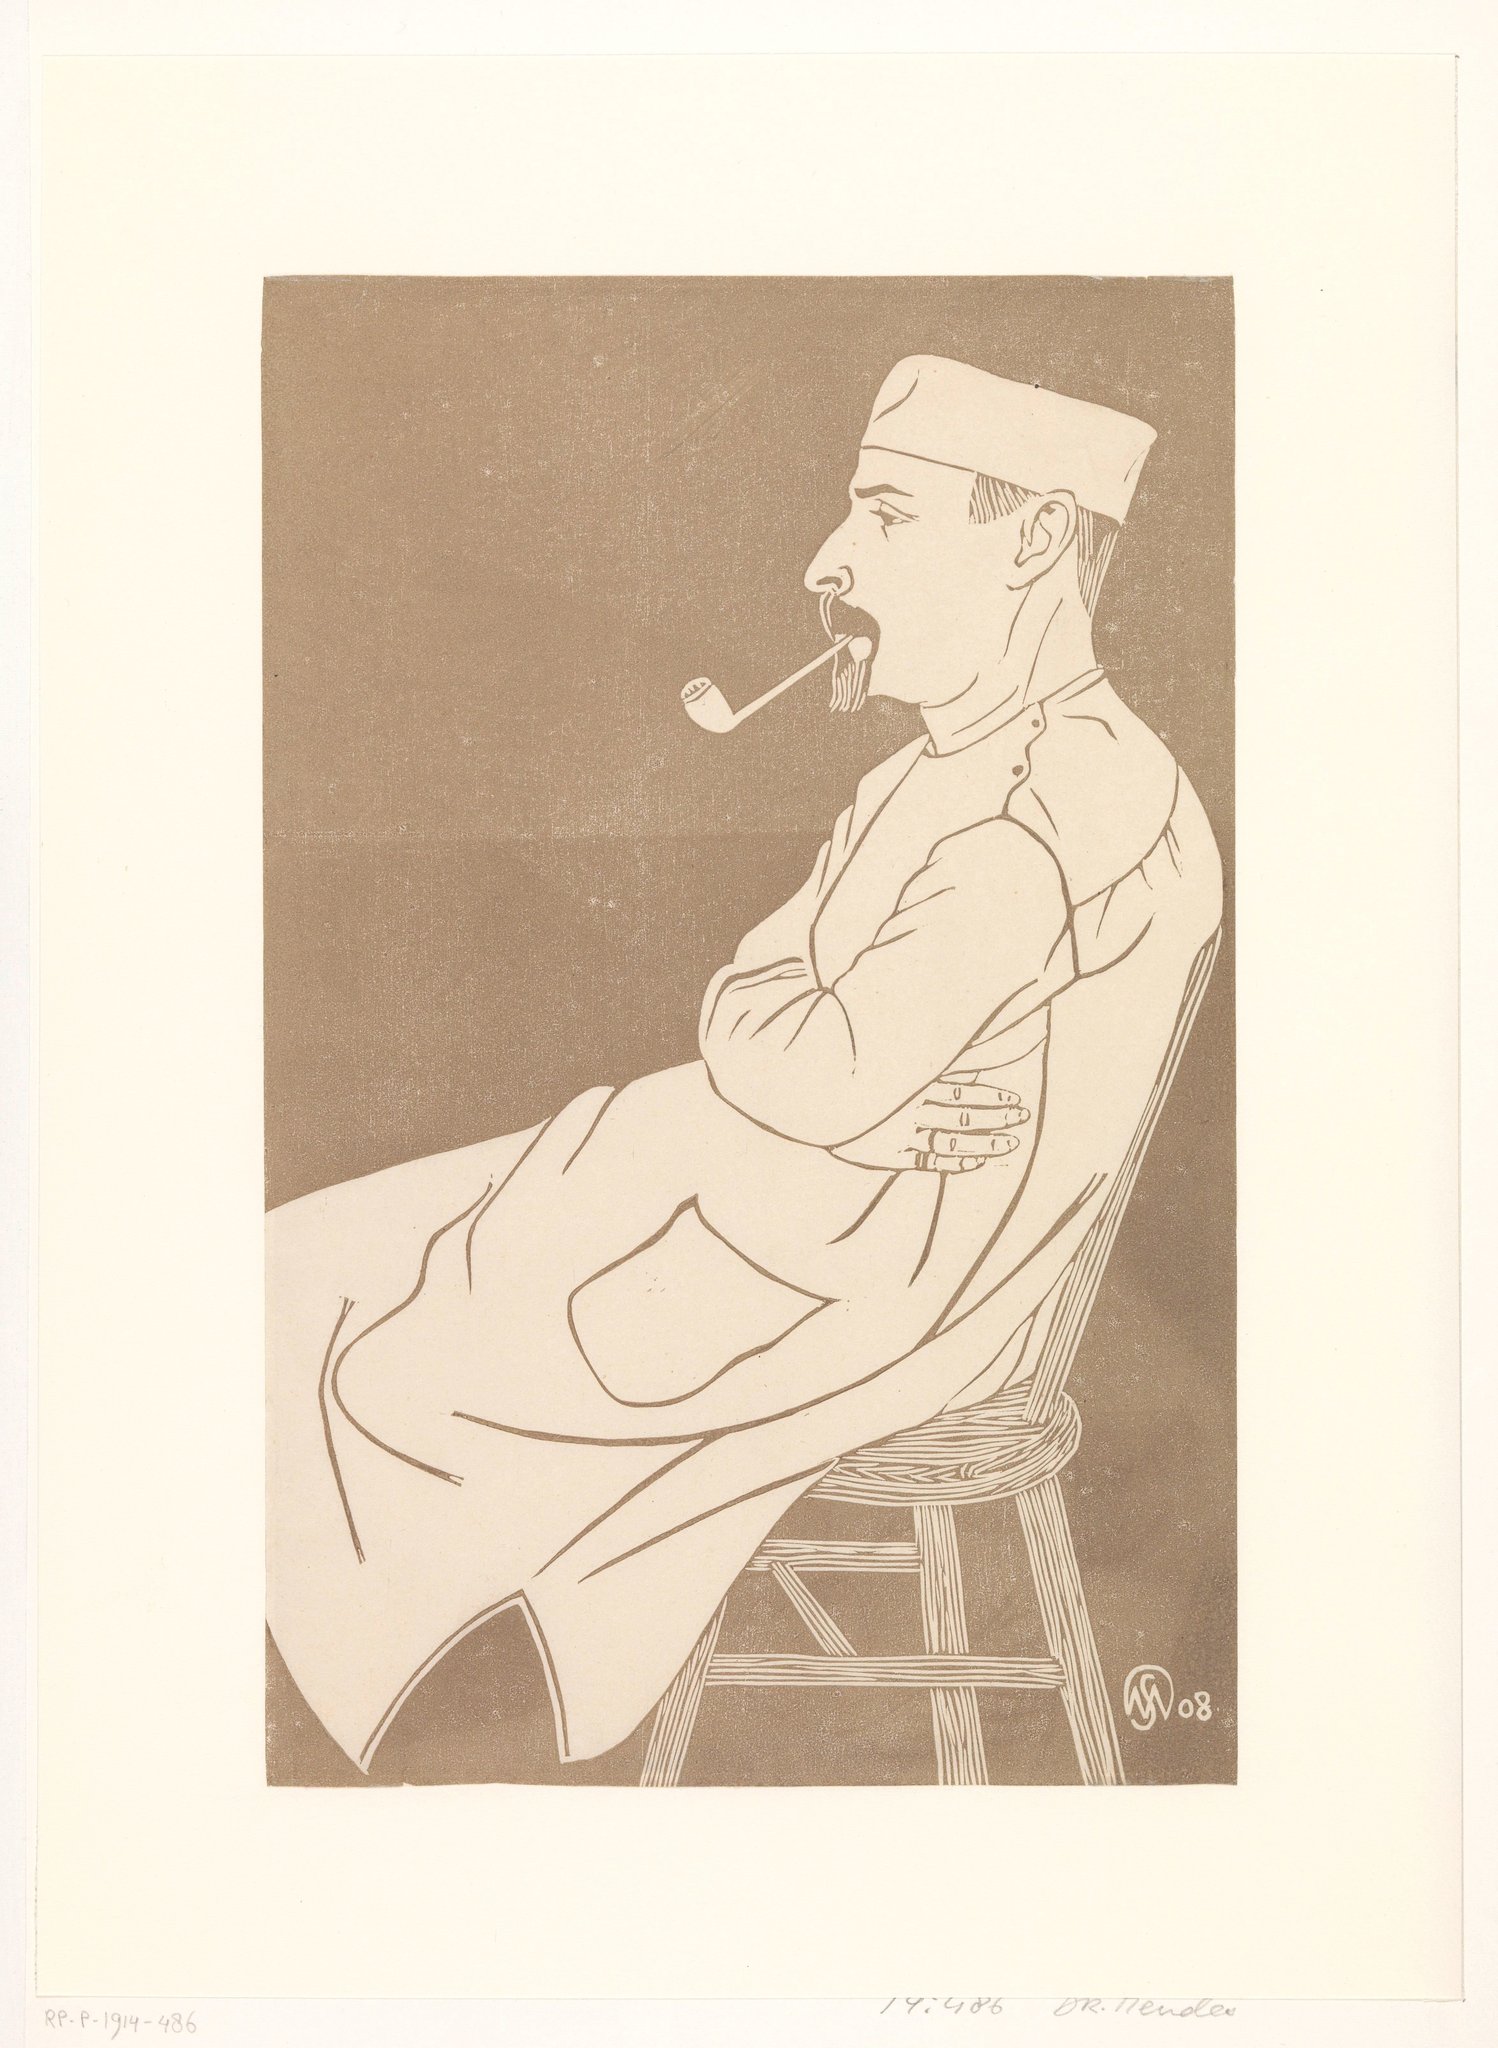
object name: print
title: Joseph Mendes da Costa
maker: samuel jessurun de mesquita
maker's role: draughtsman, print maker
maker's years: 1868-1944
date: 1908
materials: paper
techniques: woodcut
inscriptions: monogram and date: ‘JM 08’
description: Zittende man en profil weergegeven met pet en pijp.